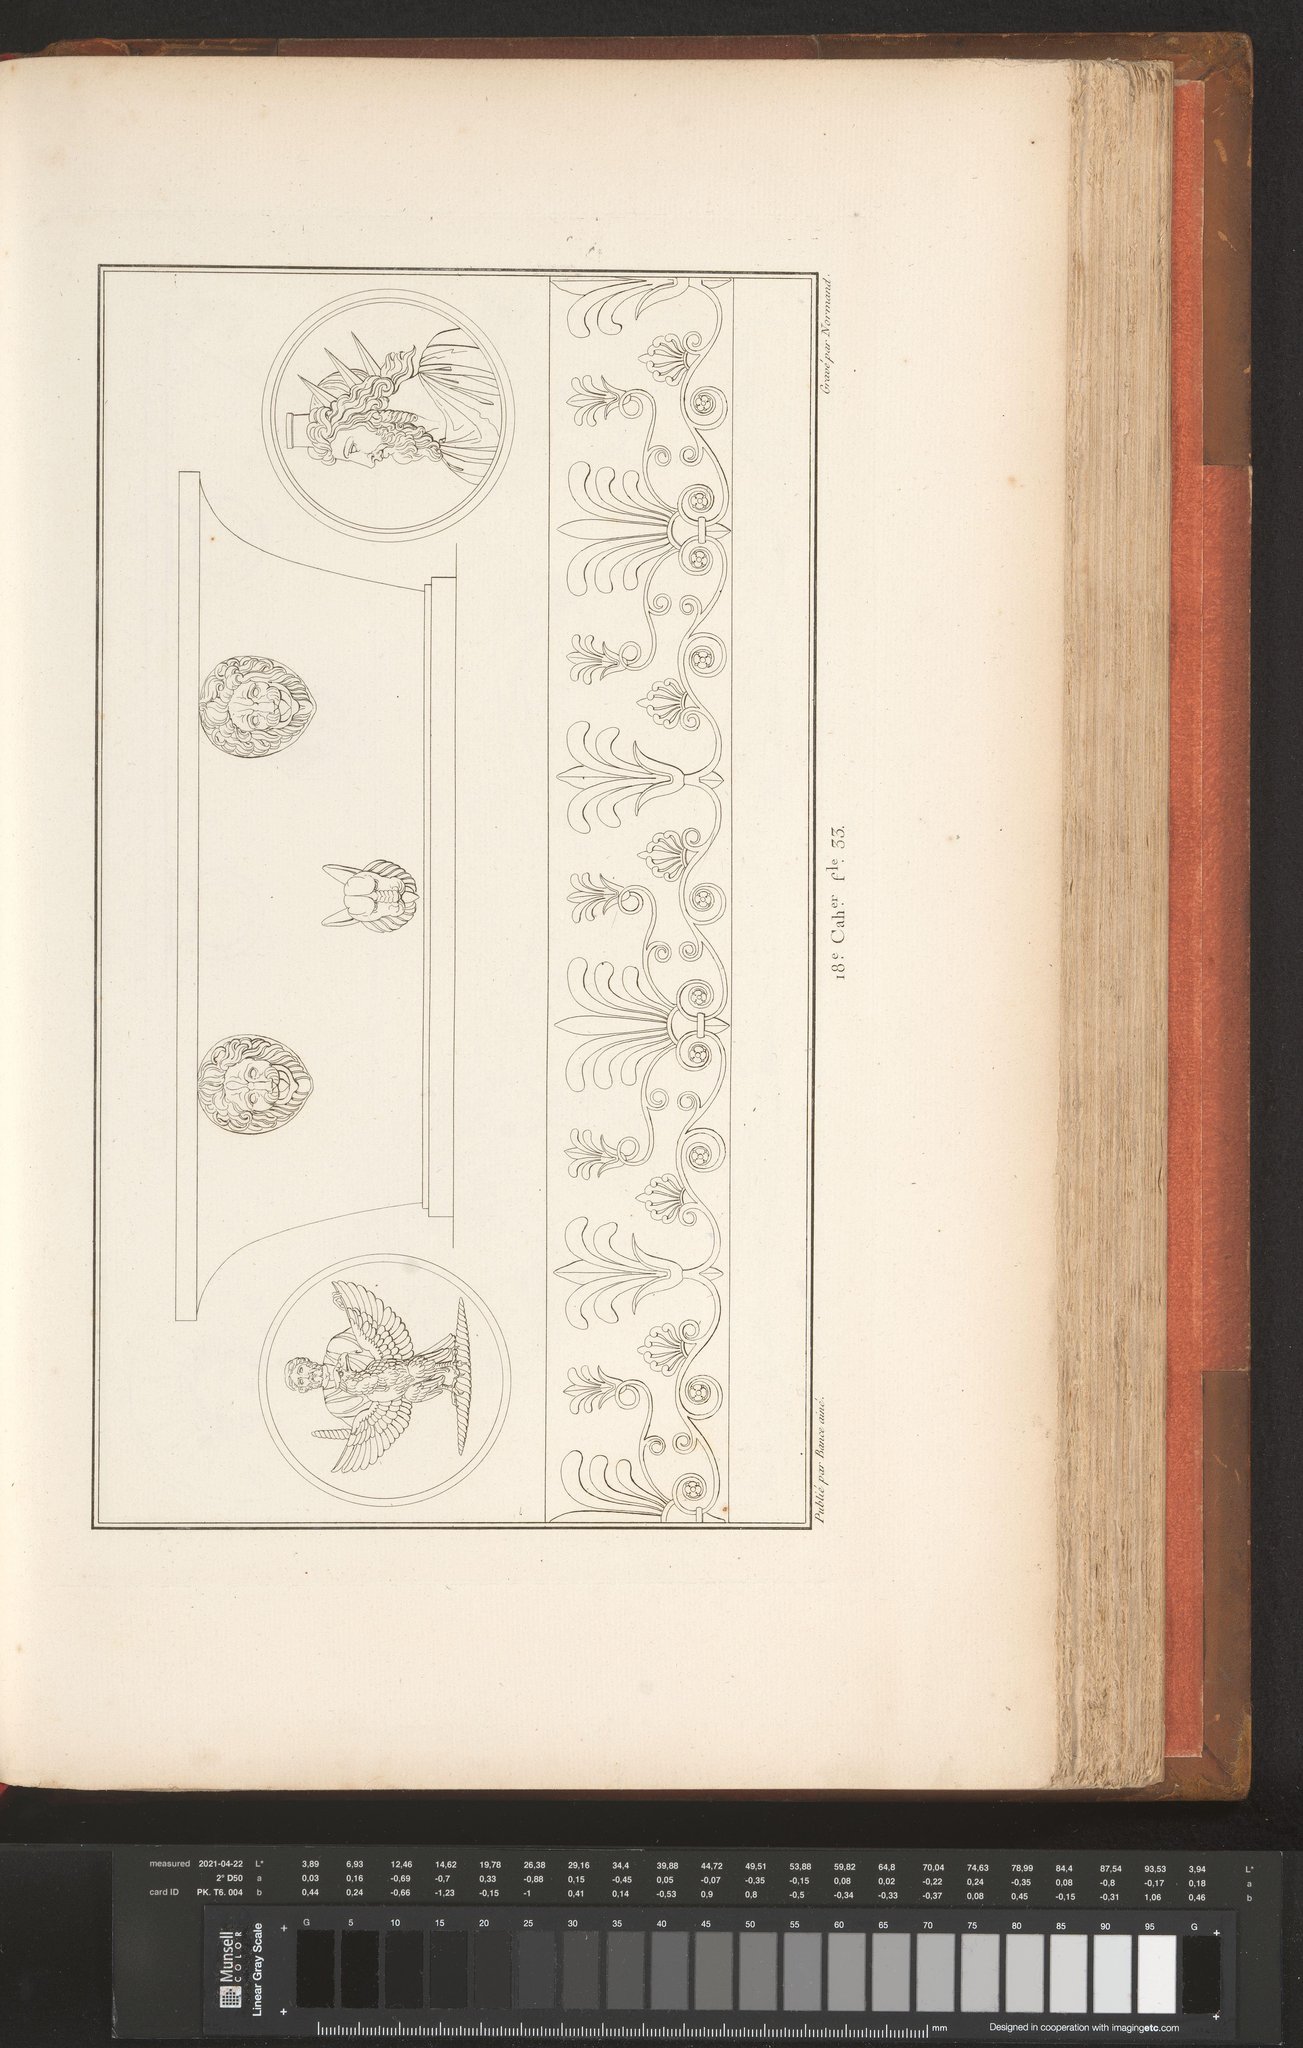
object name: ornament print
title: Fries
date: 1820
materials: paper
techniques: etching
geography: paris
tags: sarcophagus, bath-tub, ornament derived from plant forms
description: Ornamentprent met een fries en een soort bak of tobbe. Onderdeel (18e. Cah.er f.le 33) van het prentalbum met twee series van in totaal 138 ornamentprenten door Beauvallet en Normand, 'Fragmens d'Ornemens dans le Style Antique'.